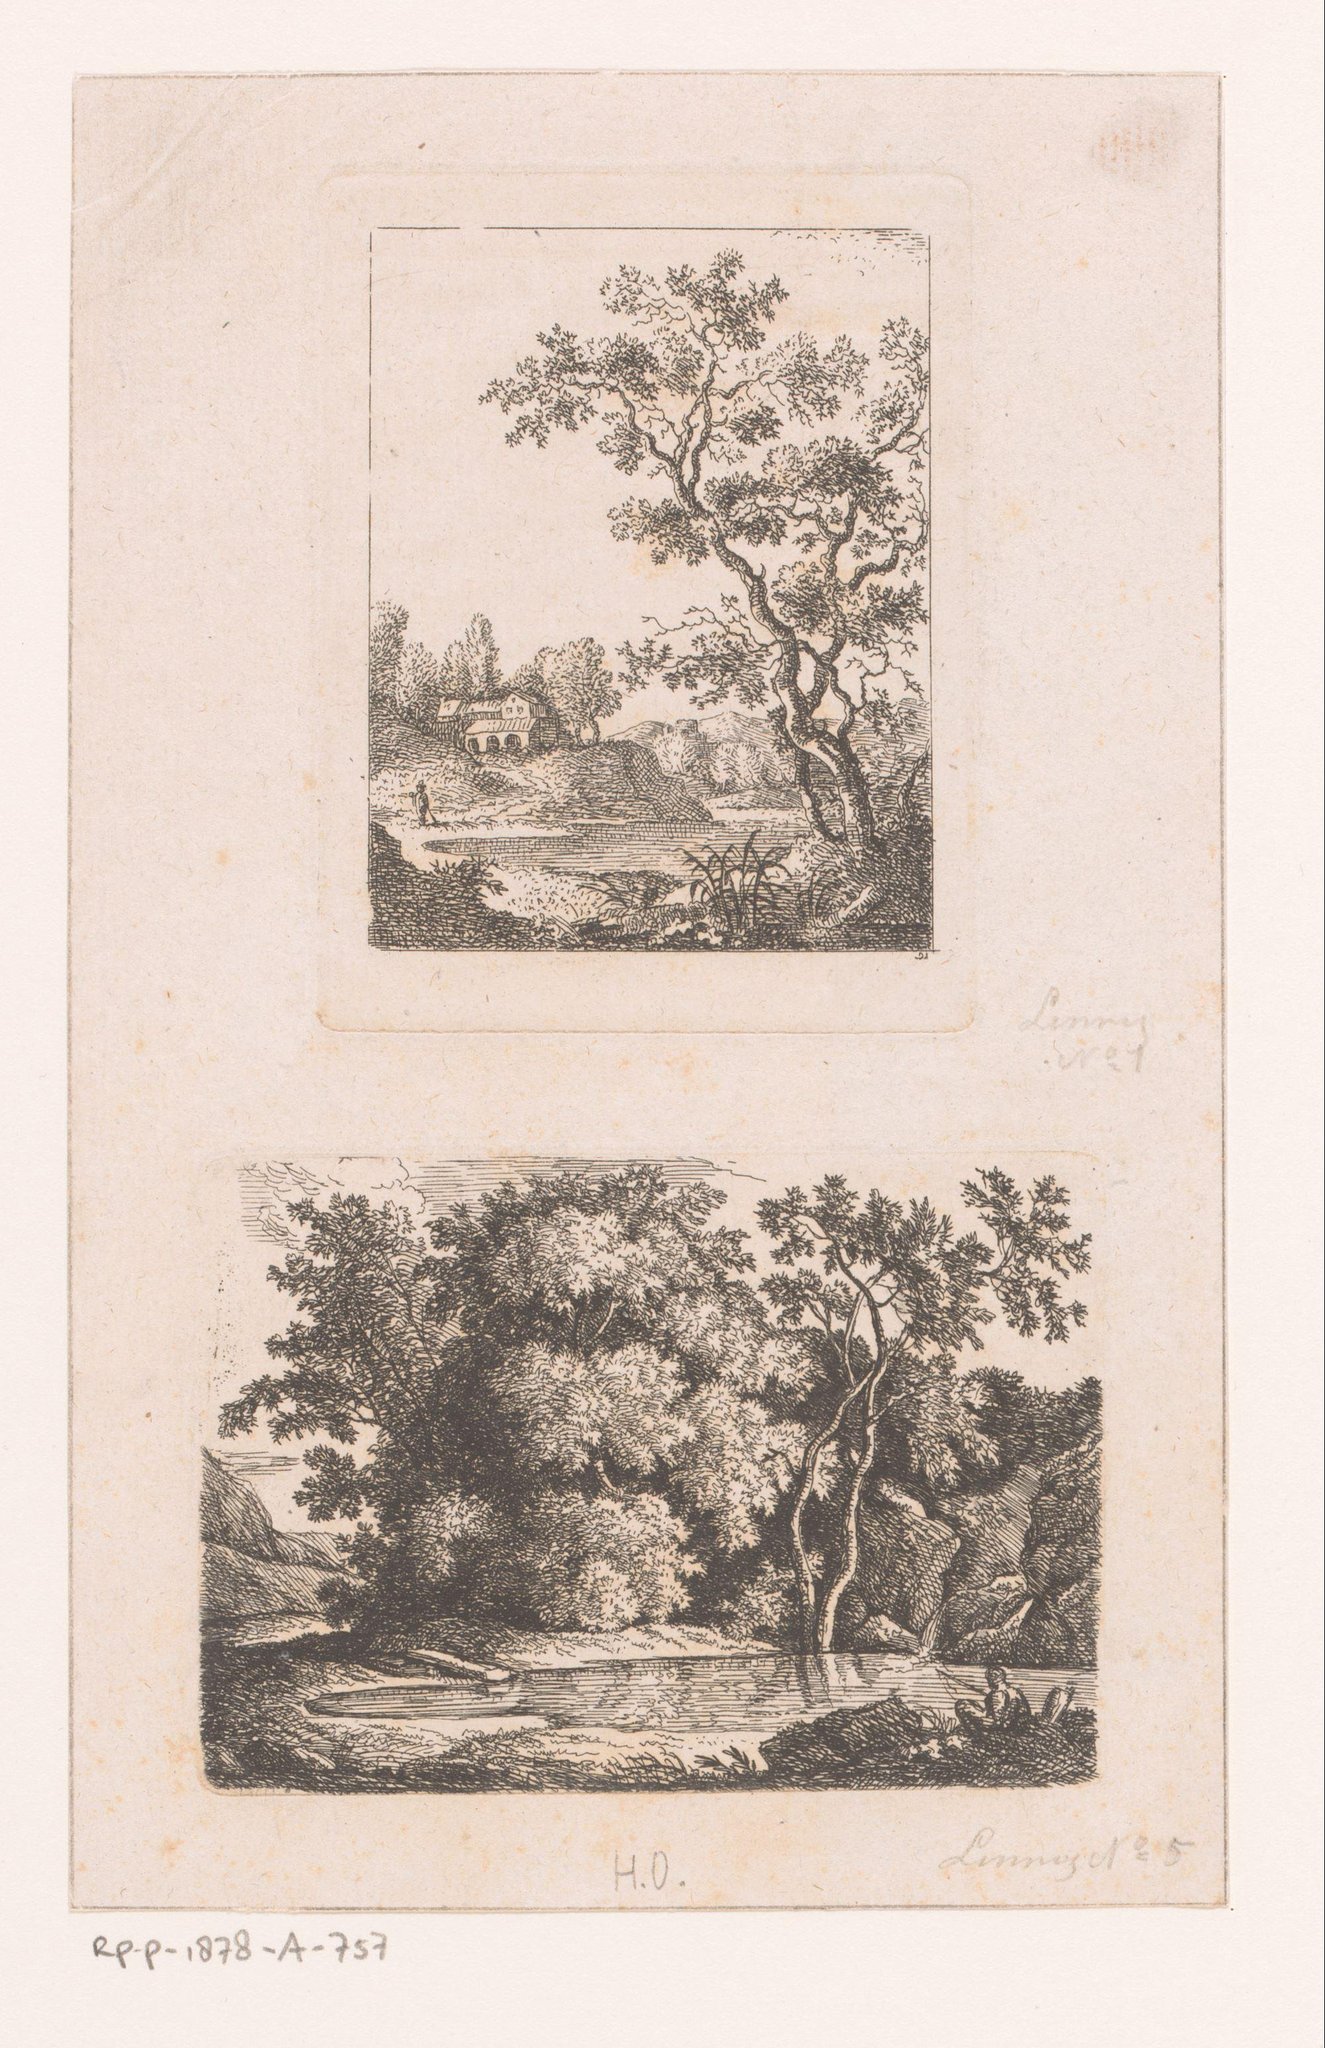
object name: print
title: Twee landschappen met heuvels, een meer en bebossing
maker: joseph charles cogels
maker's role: print maker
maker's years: 1785-1831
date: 1795-1831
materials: paper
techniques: etching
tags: lake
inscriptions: collector's mark: Lugt 2228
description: Het bovenste landschap is een meer met twee bomen op de voorgrond en bebouwing op de achtergrond. Het onderste landschap is een meer met een visser.